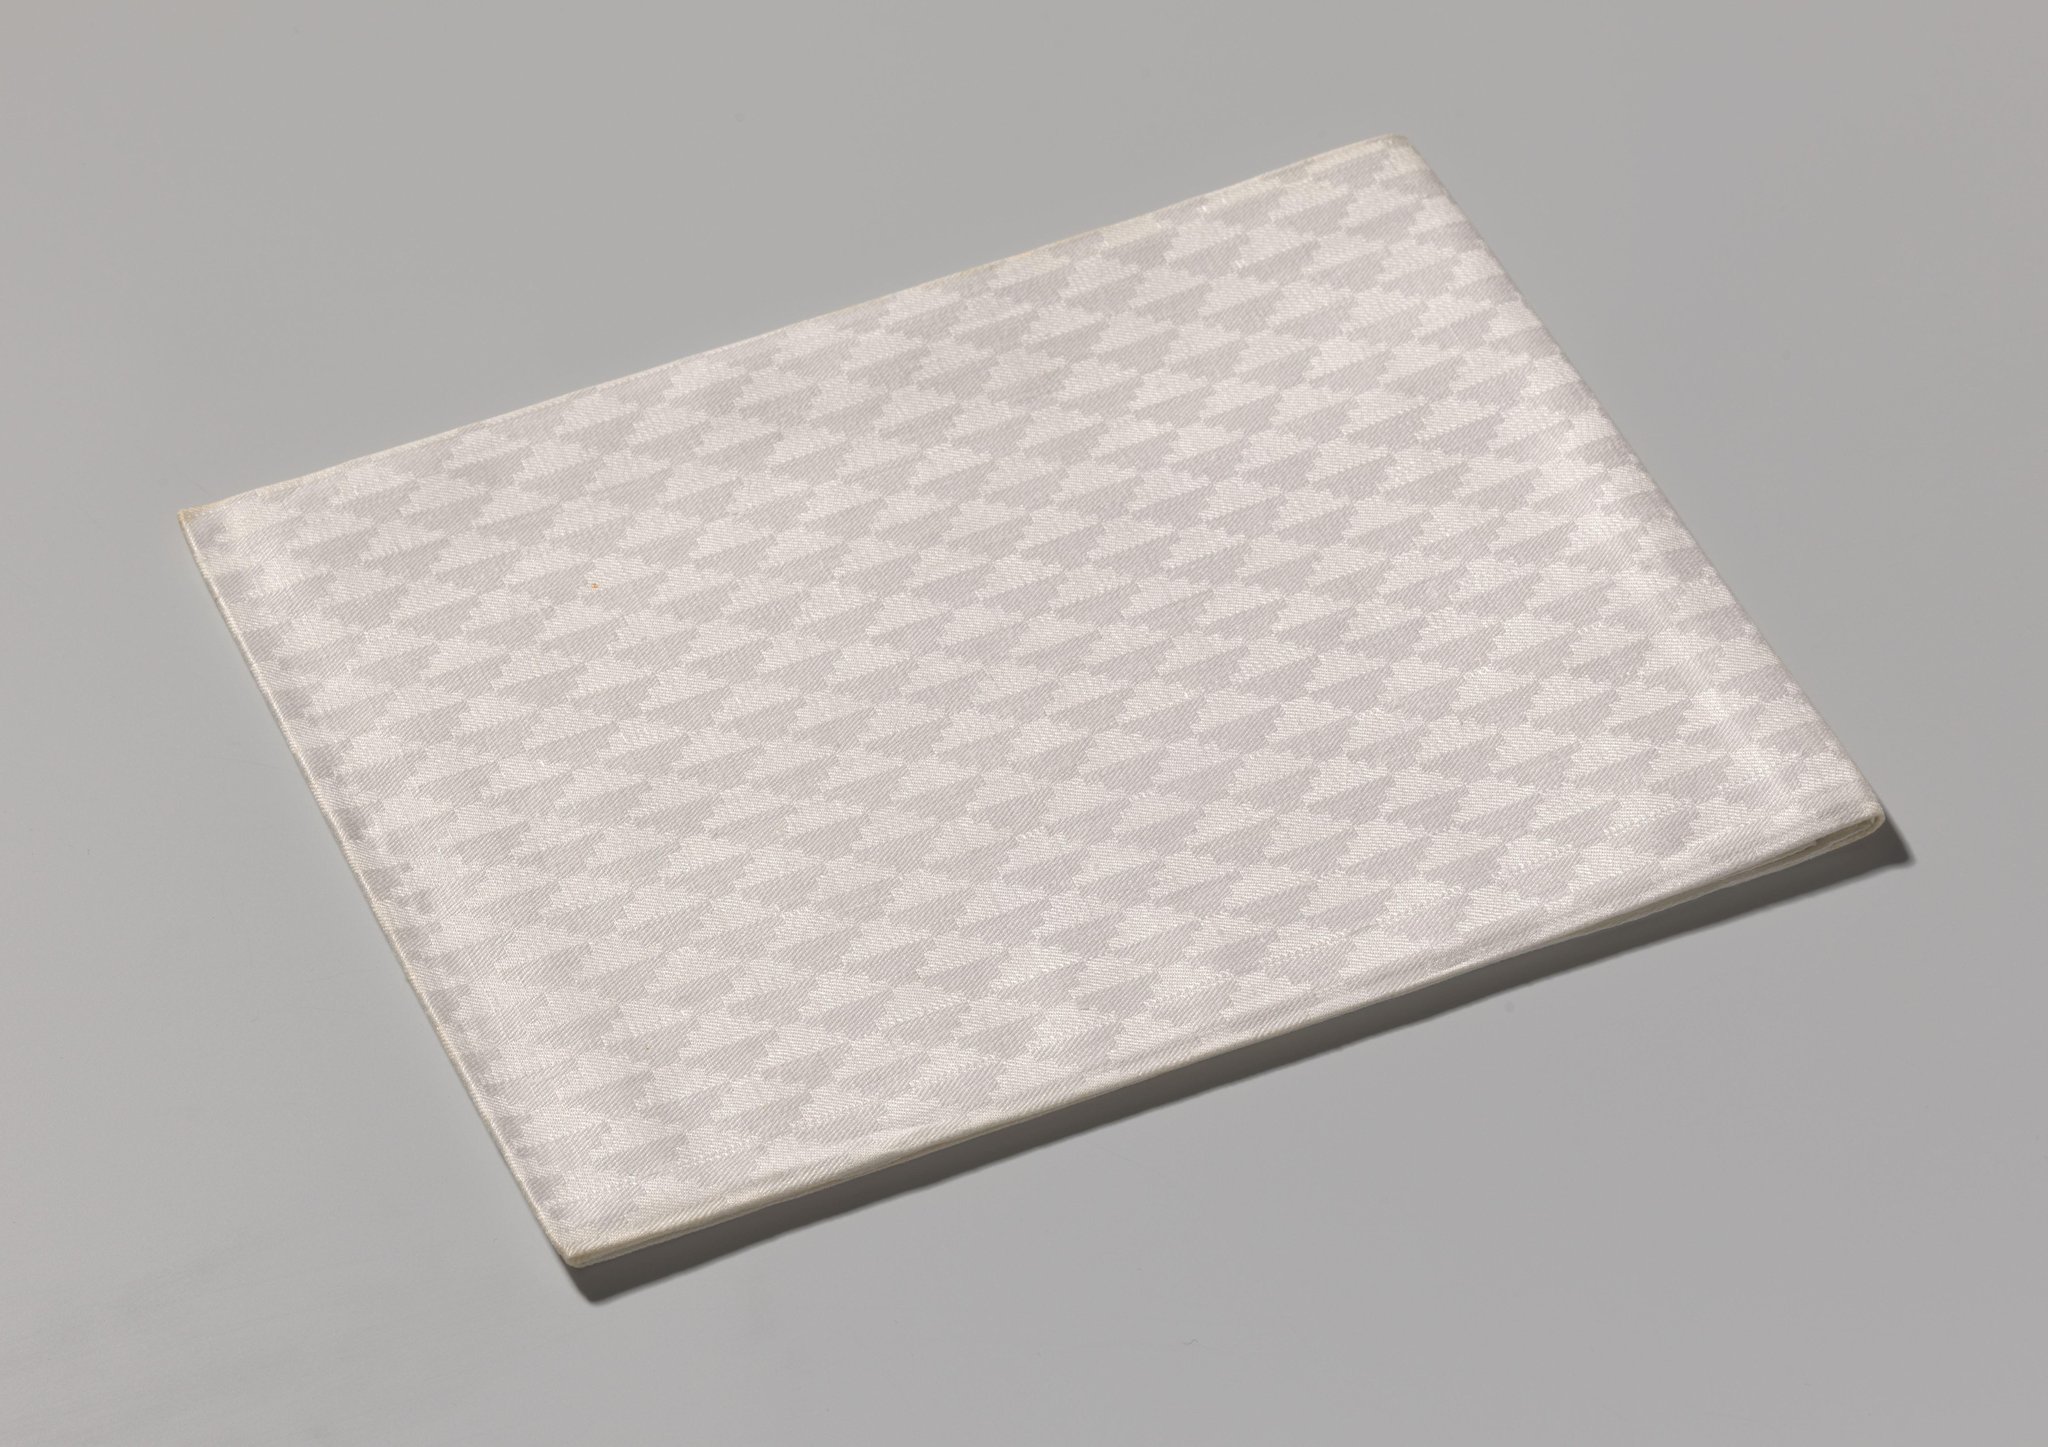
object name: napkin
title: Servet van linnen met pellenpatroon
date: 1767-1816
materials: linen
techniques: peeled fabric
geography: northern netherlands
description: Wit linnendamasten servet met pellenpatroon, merk WS en 24.